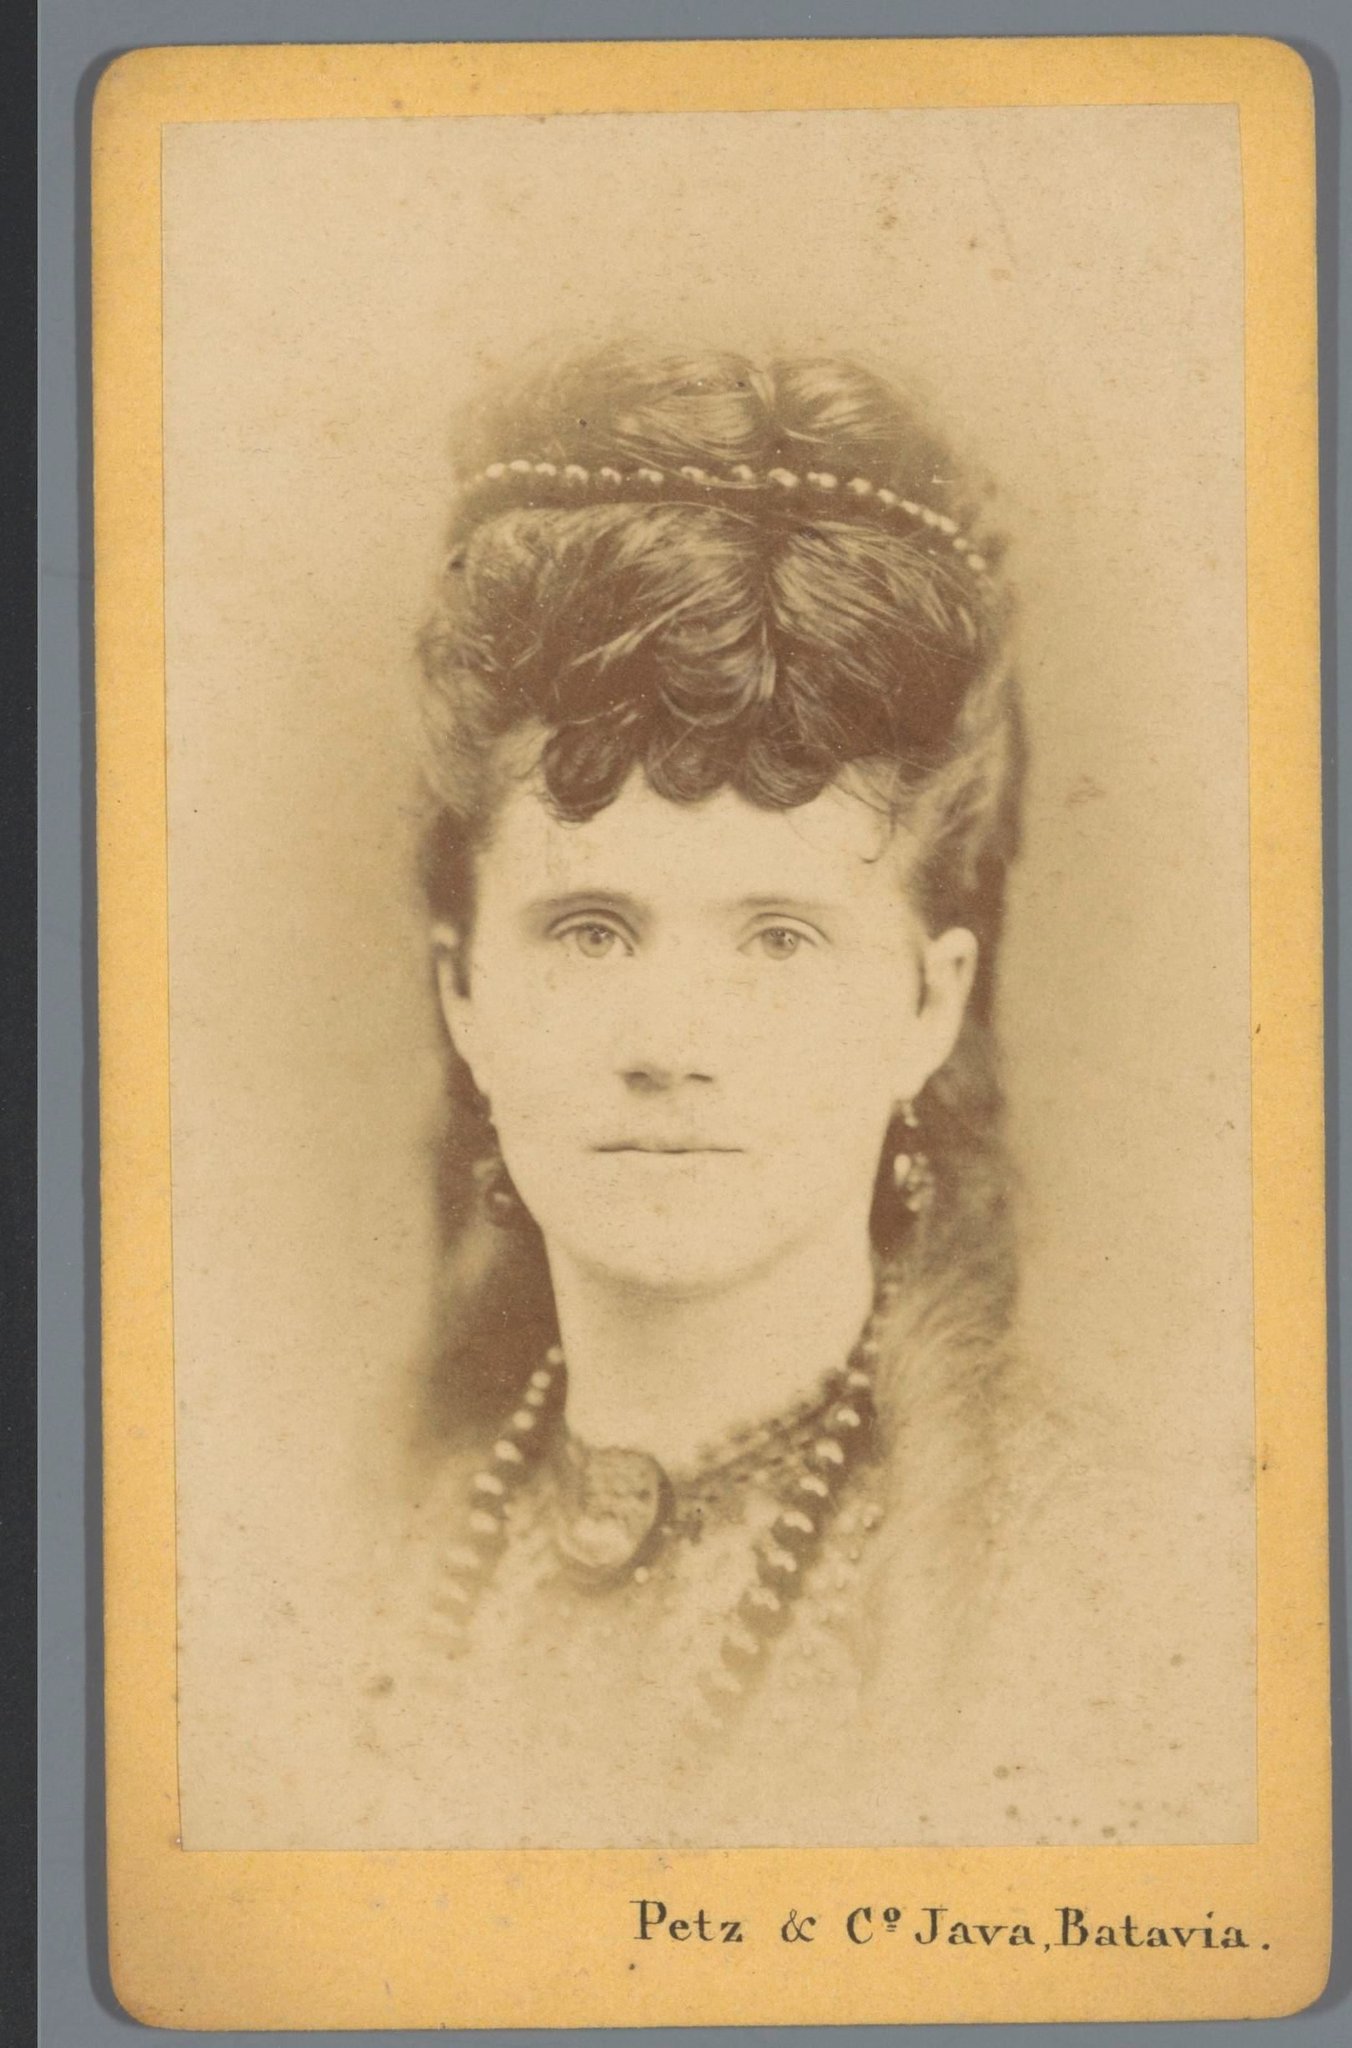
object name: photograph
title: Portret van een onbekende vrouw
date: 1809-1871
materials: cardboard, paper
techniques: albumen print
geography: batavia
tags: adult woman, anonymous historical person portrayed, batavia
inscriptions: inscription: ‘Gemaakt in/ Septr 1871.’, inscription: ‘voor Jan & Comté’, inscription: ‘Petz & Co Java, Batavia.’